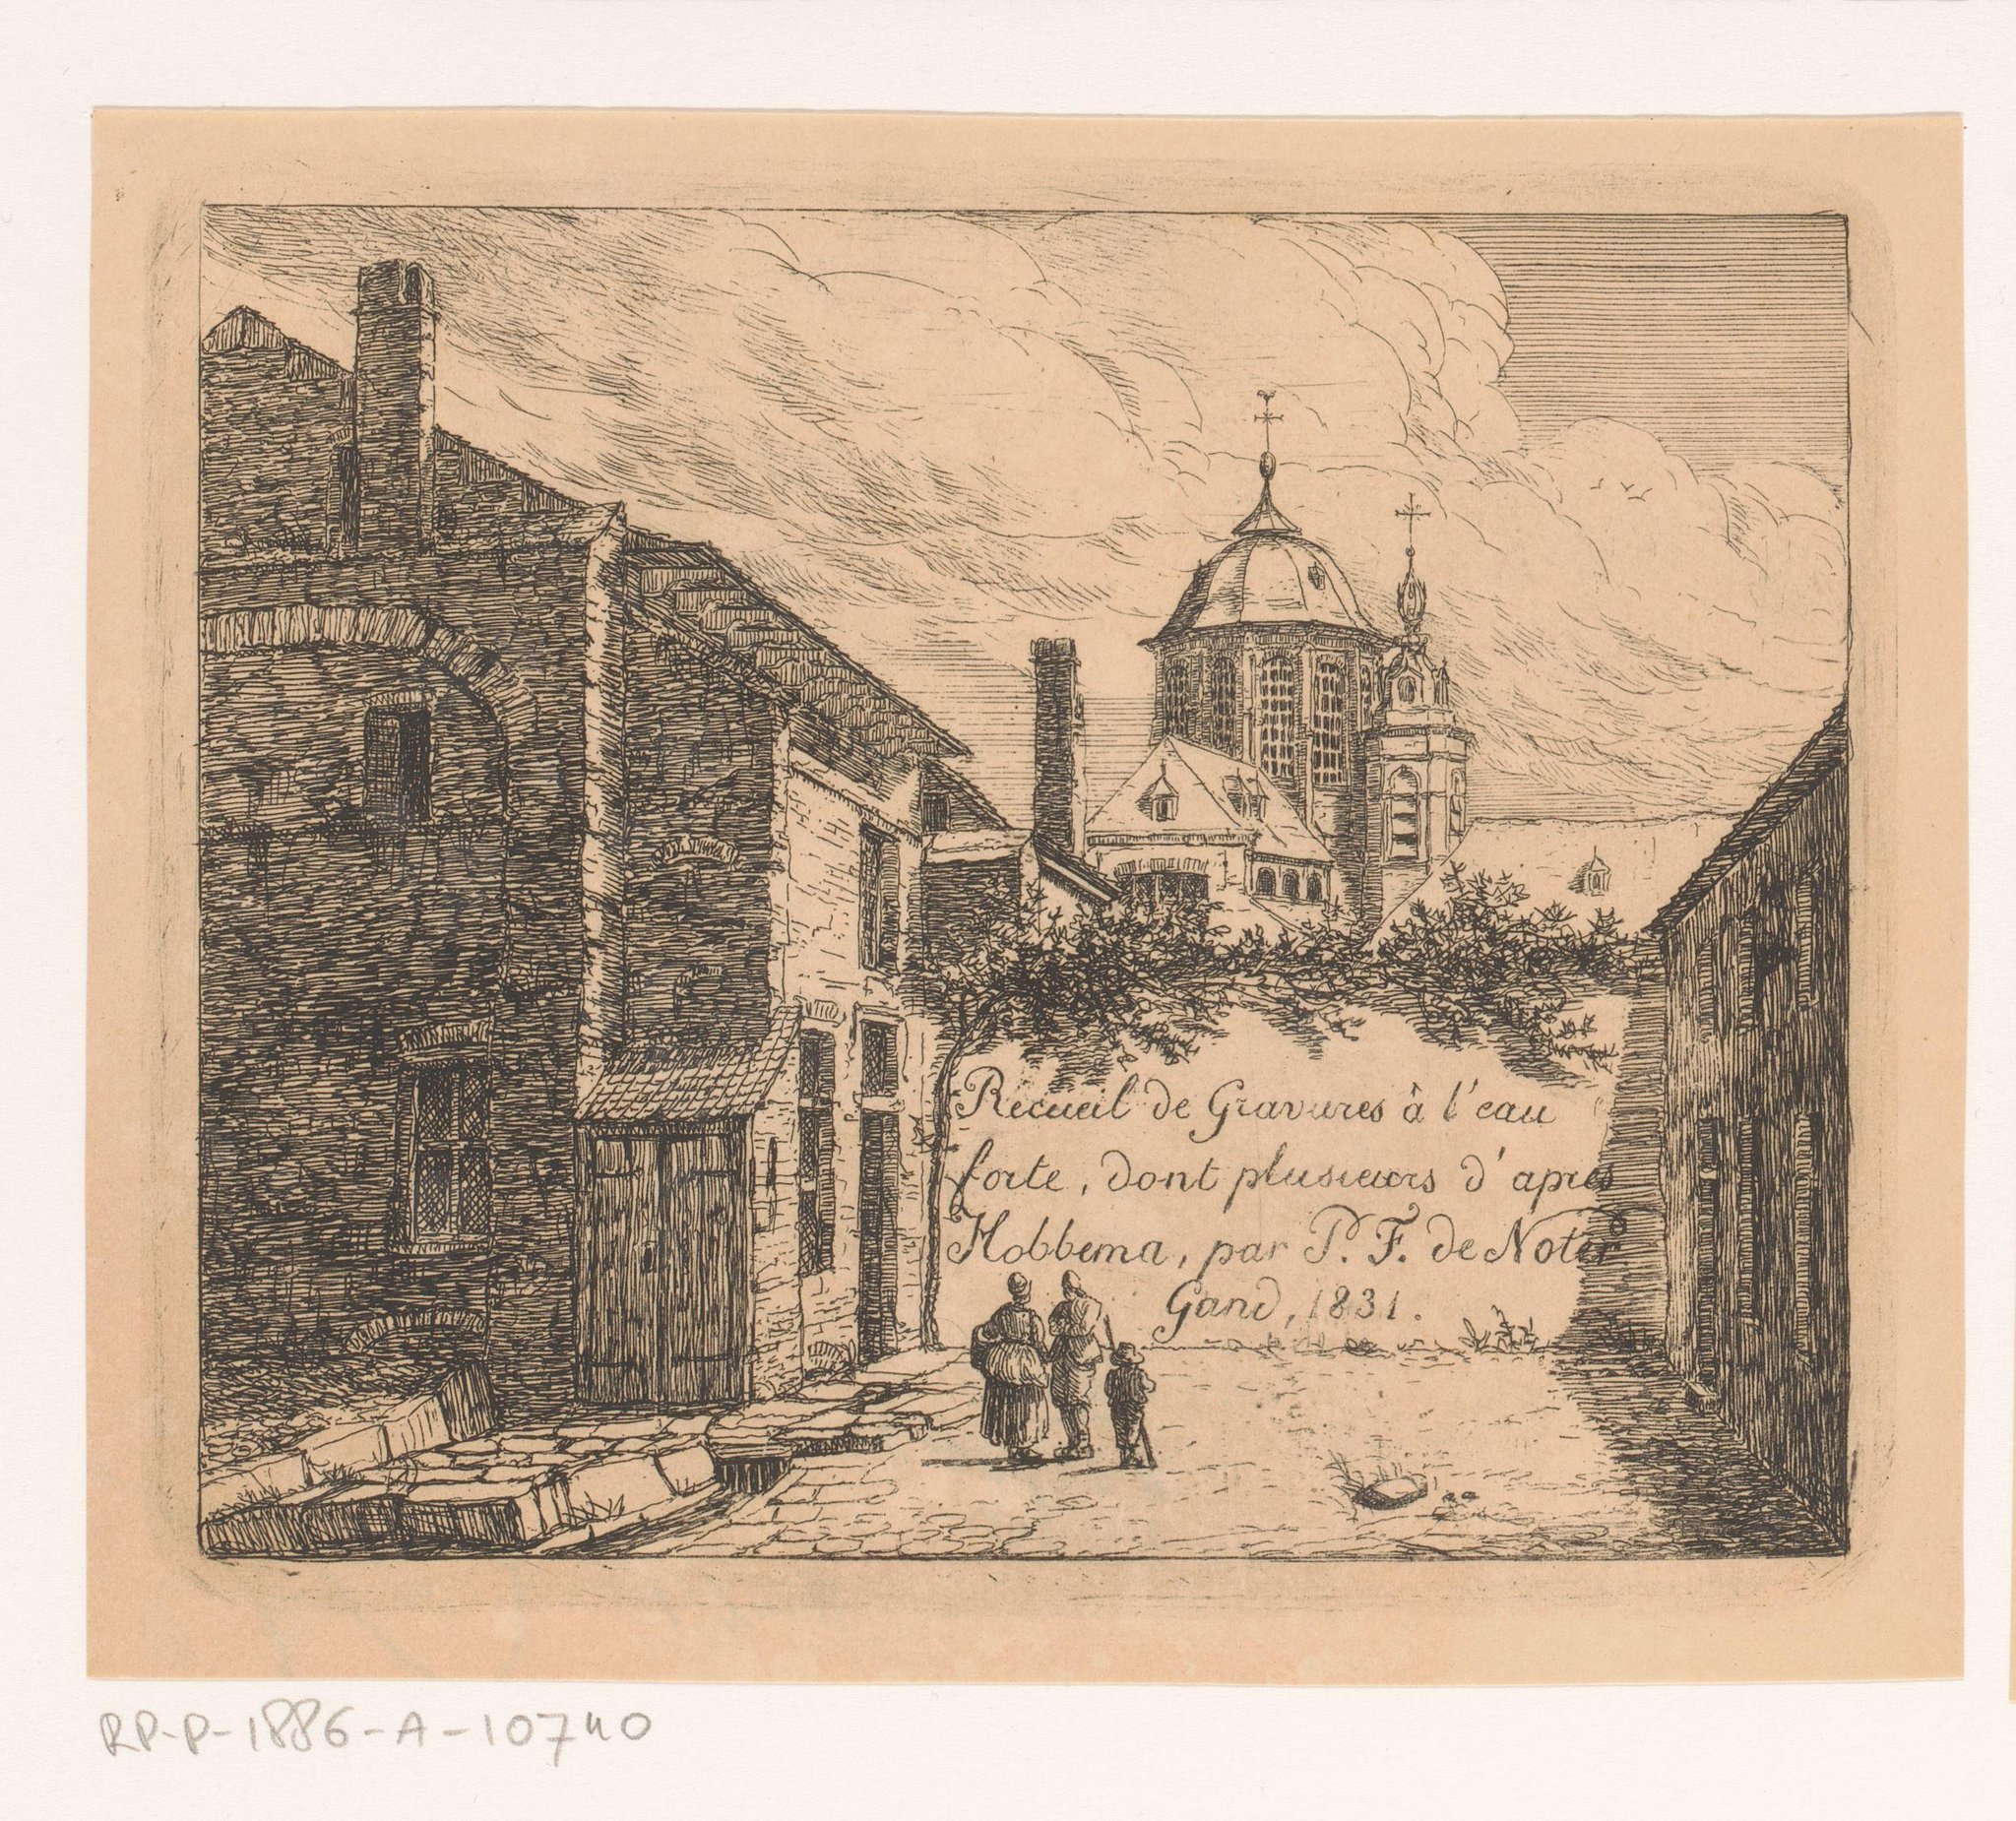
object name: titelprent, frontispice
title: Verzameling etsen door Pierre François De Noter, deels naar Meindert Hobbema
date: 1831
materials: paper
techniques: etching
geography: ghent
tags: city-view in general; 'veduta', fence, wall, paling, church (exterior)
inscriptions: collector's mark: Lugt 2228